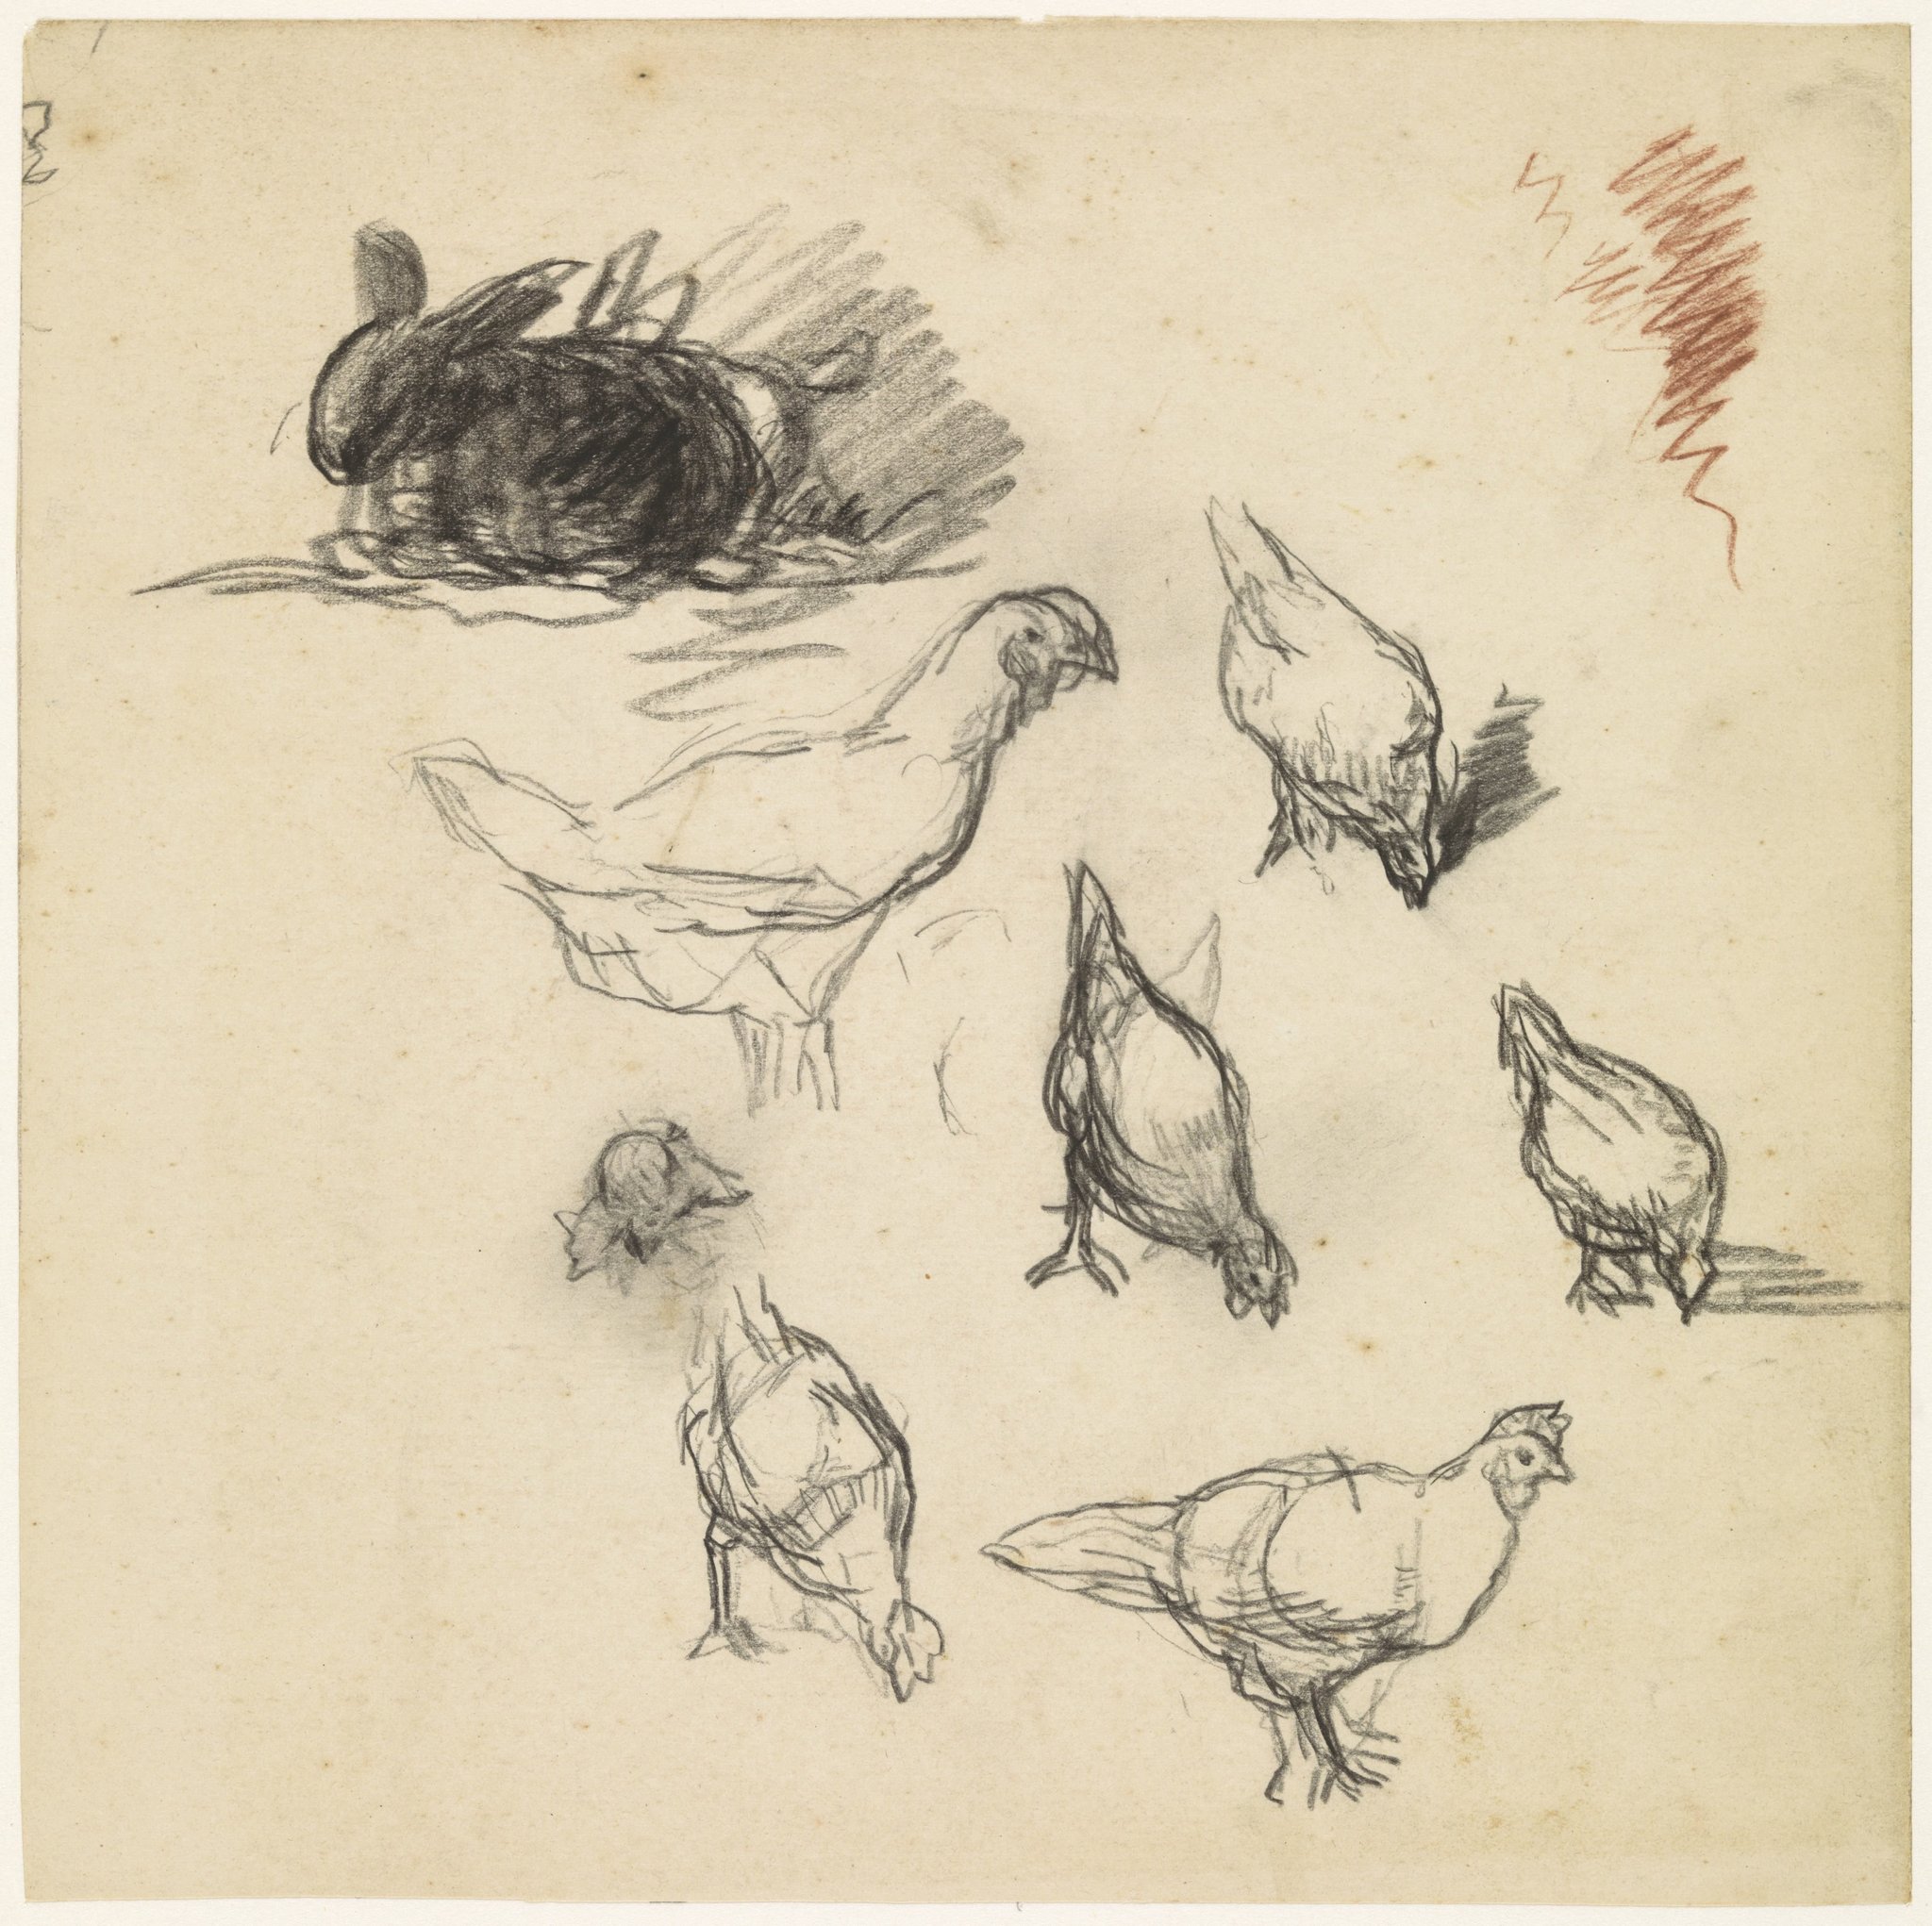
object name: drawing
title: Studieblad met schetsen van kippen en een konijn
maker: jakob smits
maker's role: draughtsman, print maker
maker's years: 1855-1928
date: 1865-1928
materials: chalk, paper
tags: fowl (cock, hen, chicken, etc.), rodents: rabbit